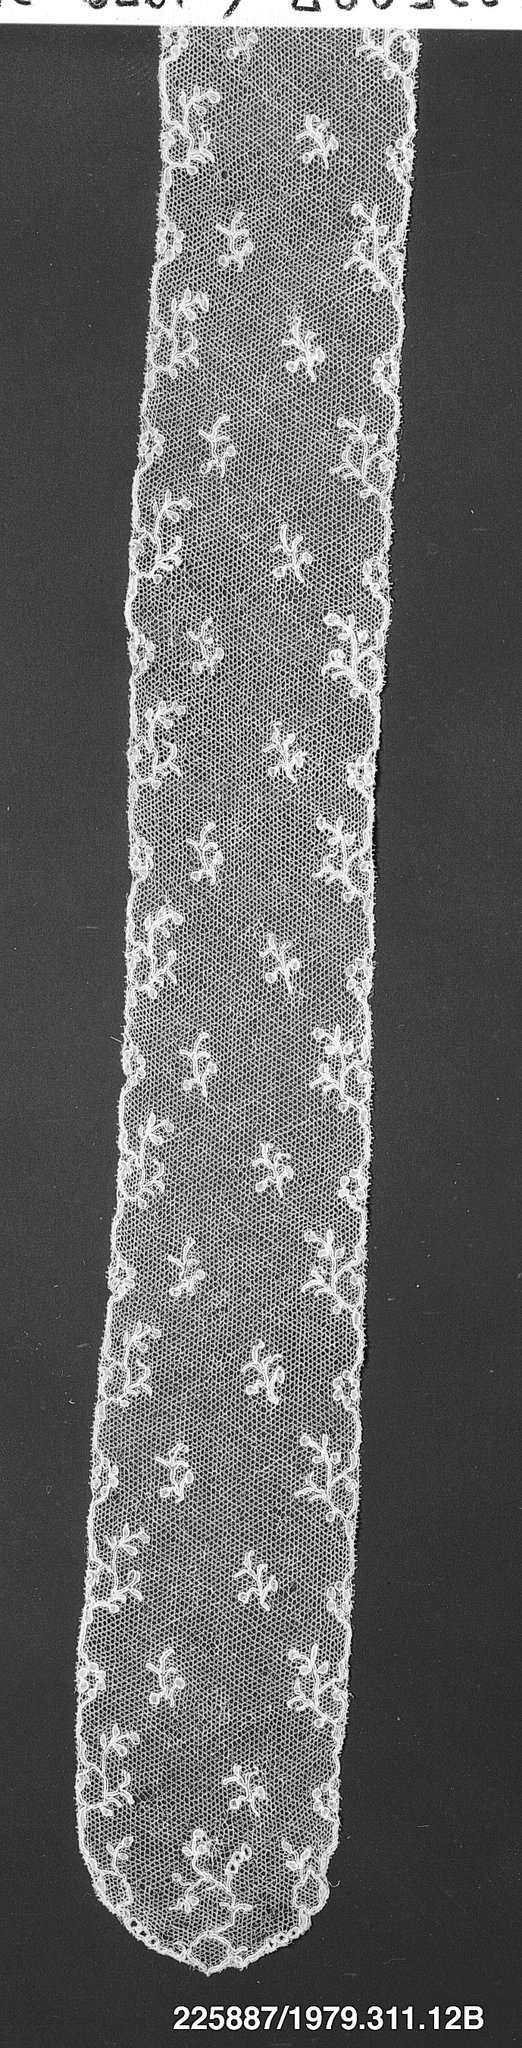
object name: lappet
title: Joined lappets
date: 1801-1833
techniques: lace